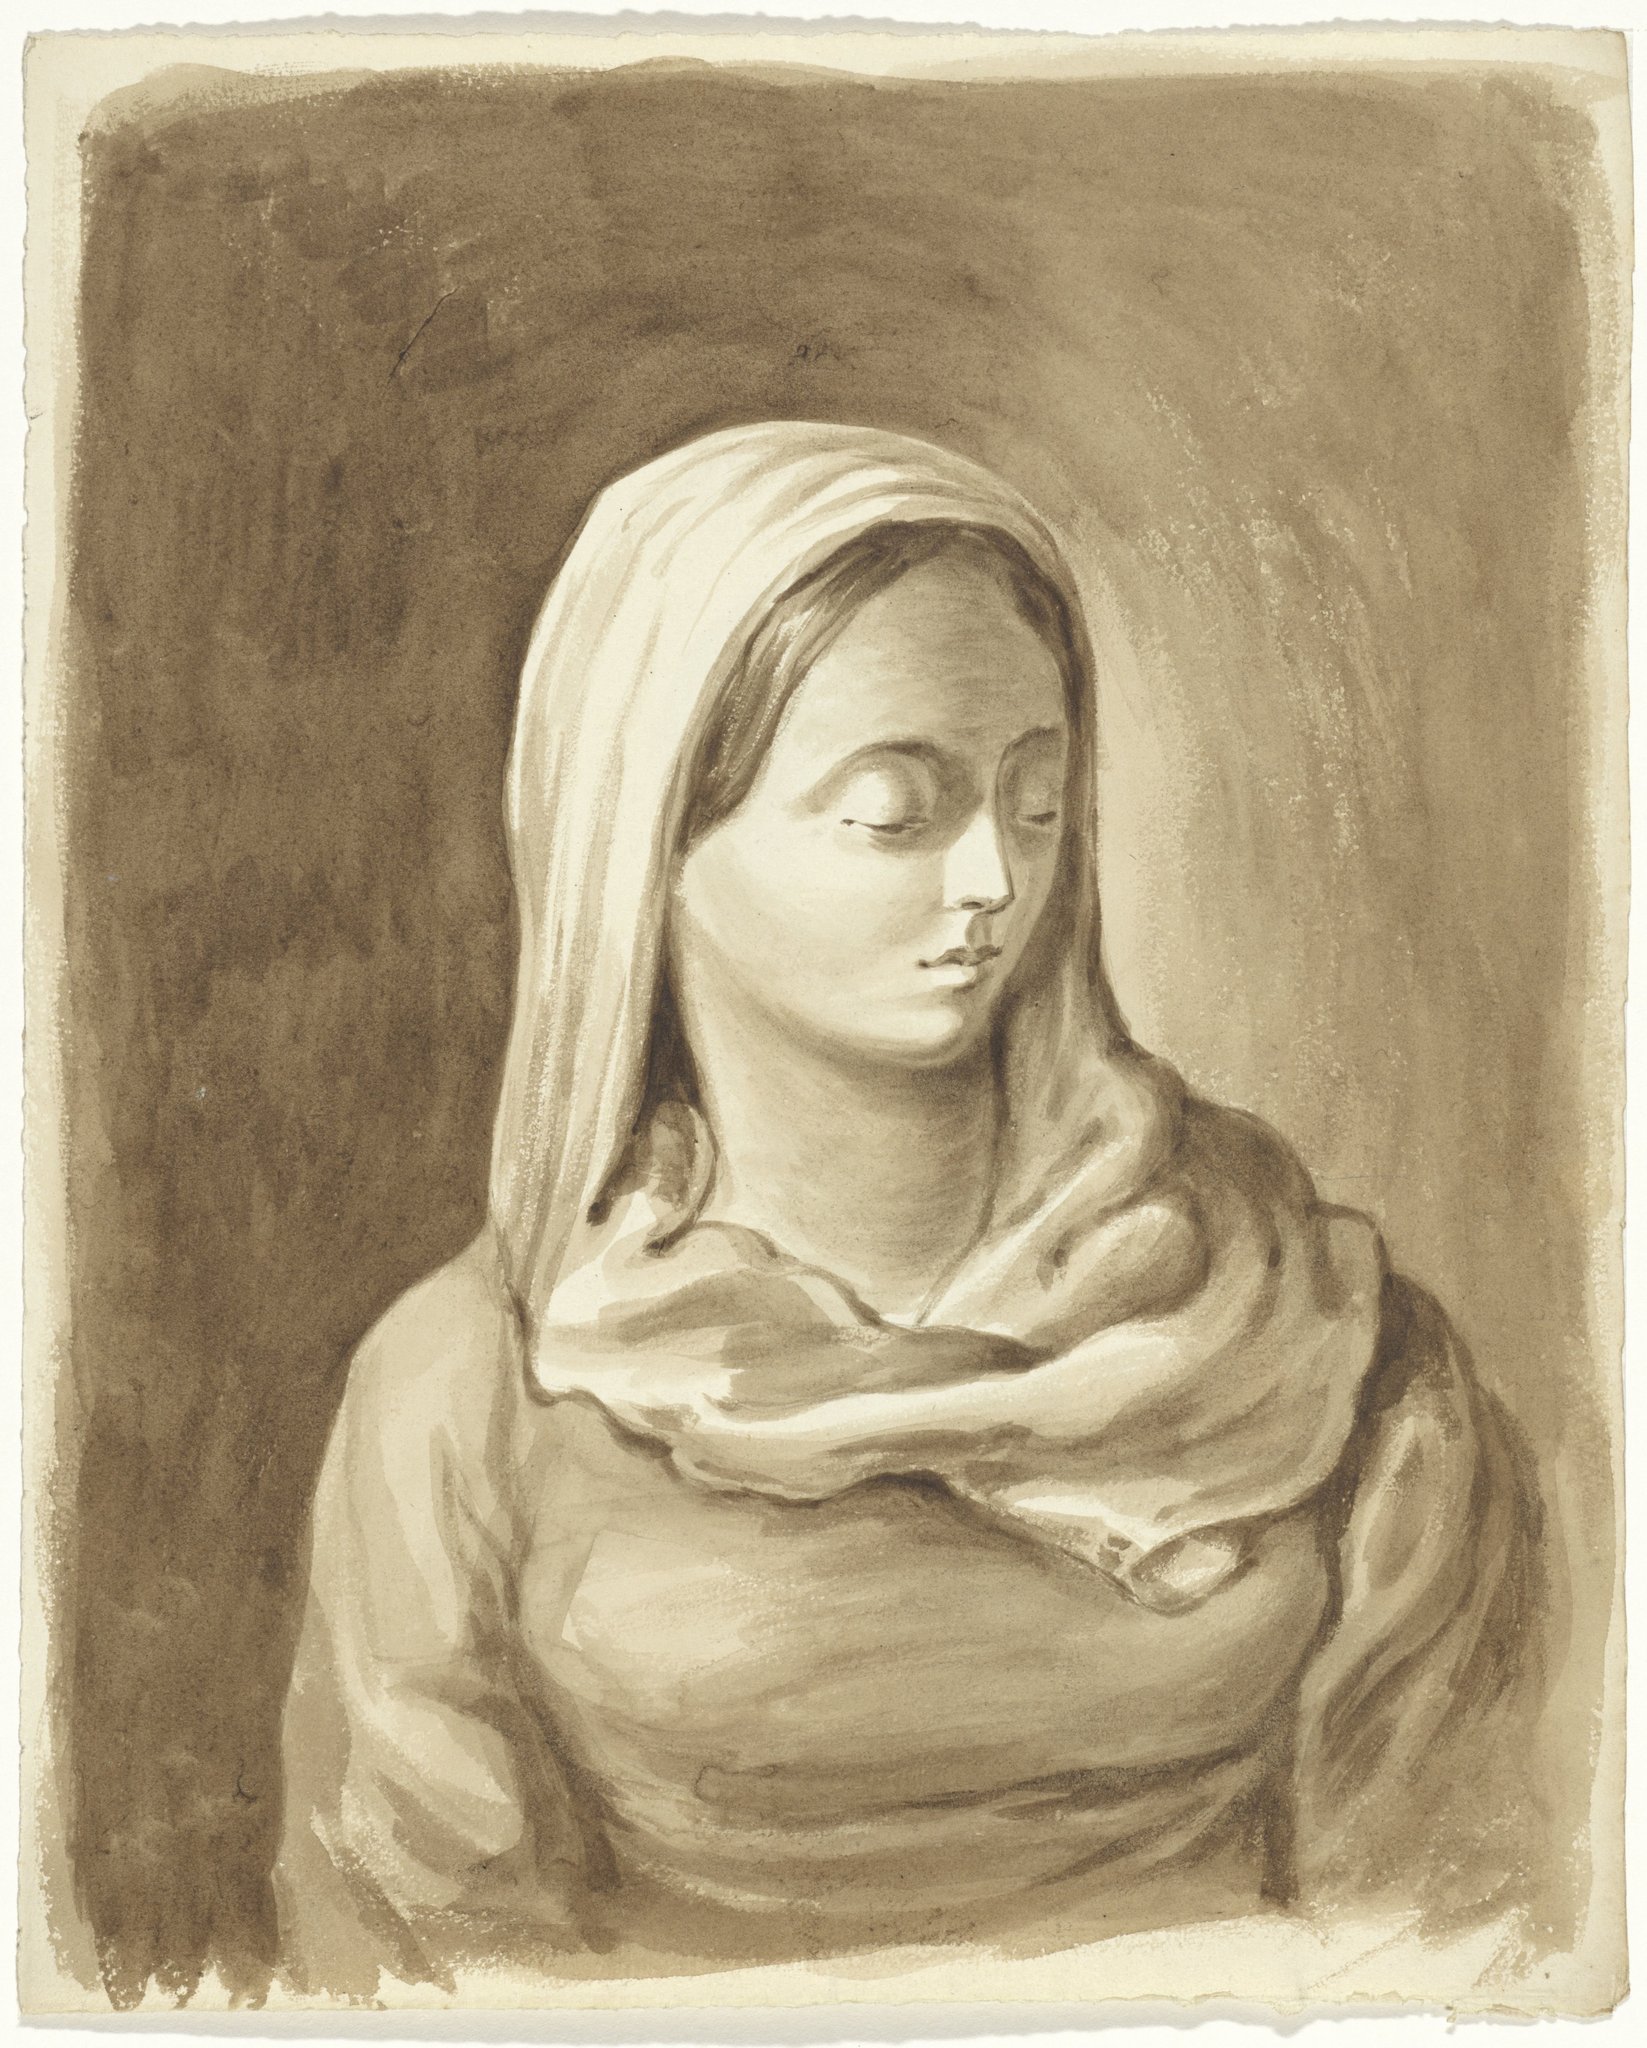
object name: drawing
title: Vrouw met hoofddoek, ten halven lijve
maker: pieter van loon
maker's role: draughtsman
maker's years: 1801-1873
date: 1811-1873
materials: paper, pencil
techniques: brush